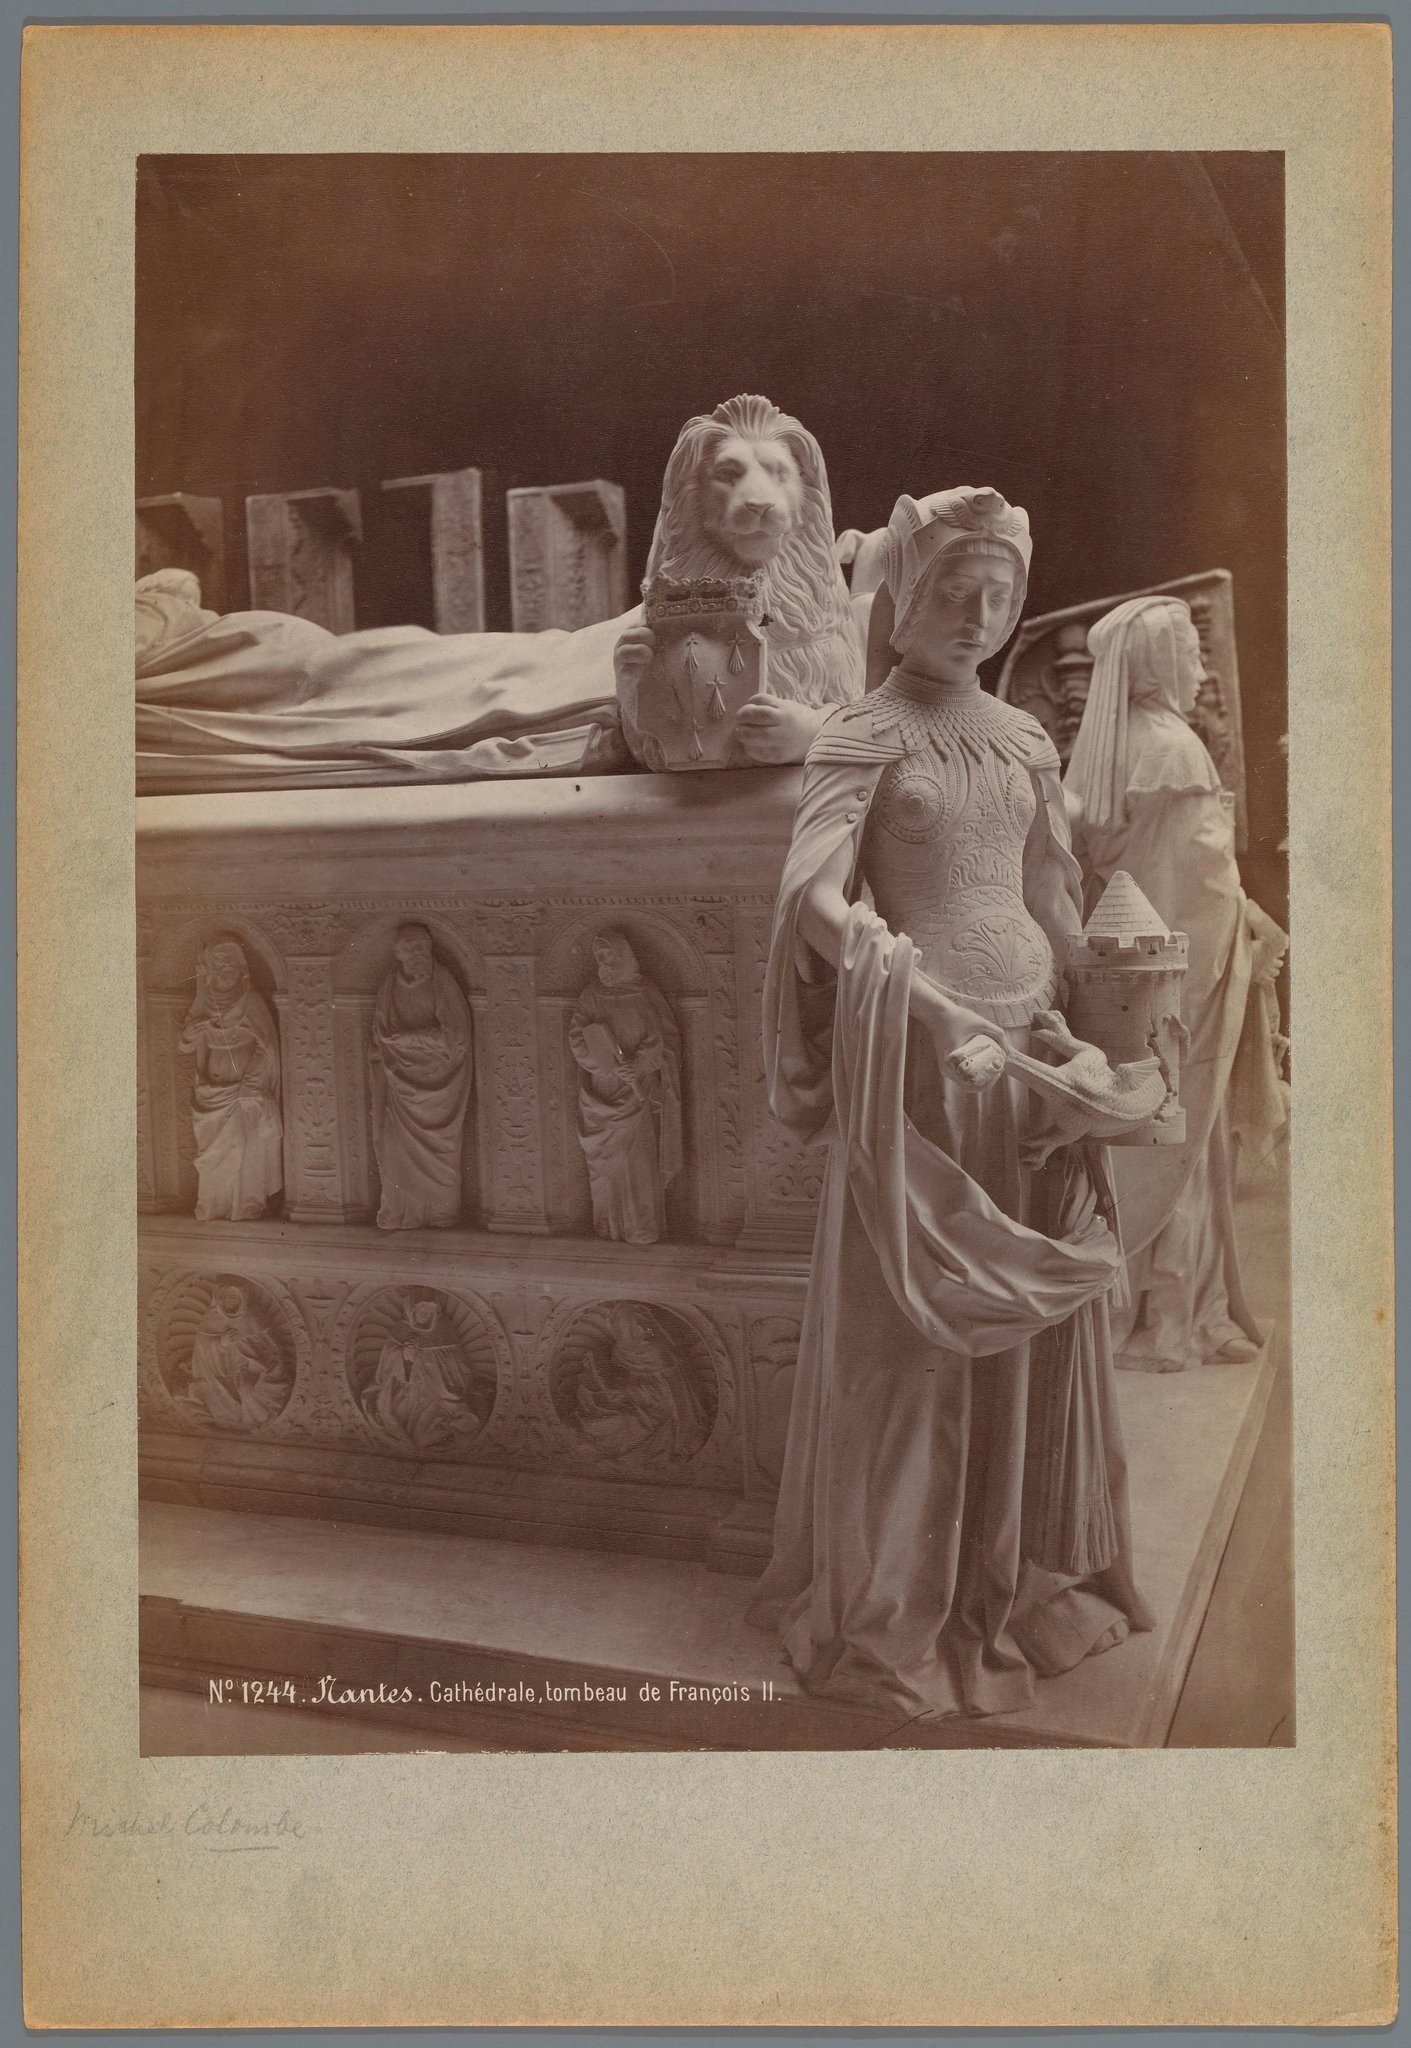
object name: photograph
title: Deel van een gipsafgietsel van de graftombe van hertog François II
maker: séraphin-médéric mieusement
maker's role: fotograaf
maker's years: 1840-1905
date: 1875-1900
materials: cardboard, photographic support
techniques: albumen print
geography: france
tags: sculpture (+ plaster ~ arts), audacity, temerity; 'audacia' (ripa) (+ personification), grave, tomb, beasts of prey, predatory animals: lion, france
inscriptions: inscription: ‘Michel Colombe’, inscription: ‘MONUMENTS HISTORIQUES’, number: ‘No. 1244.’, name: ‘MIEUSEMENT PHOTOGRAPHE’, collector's mark: Lugt 3937